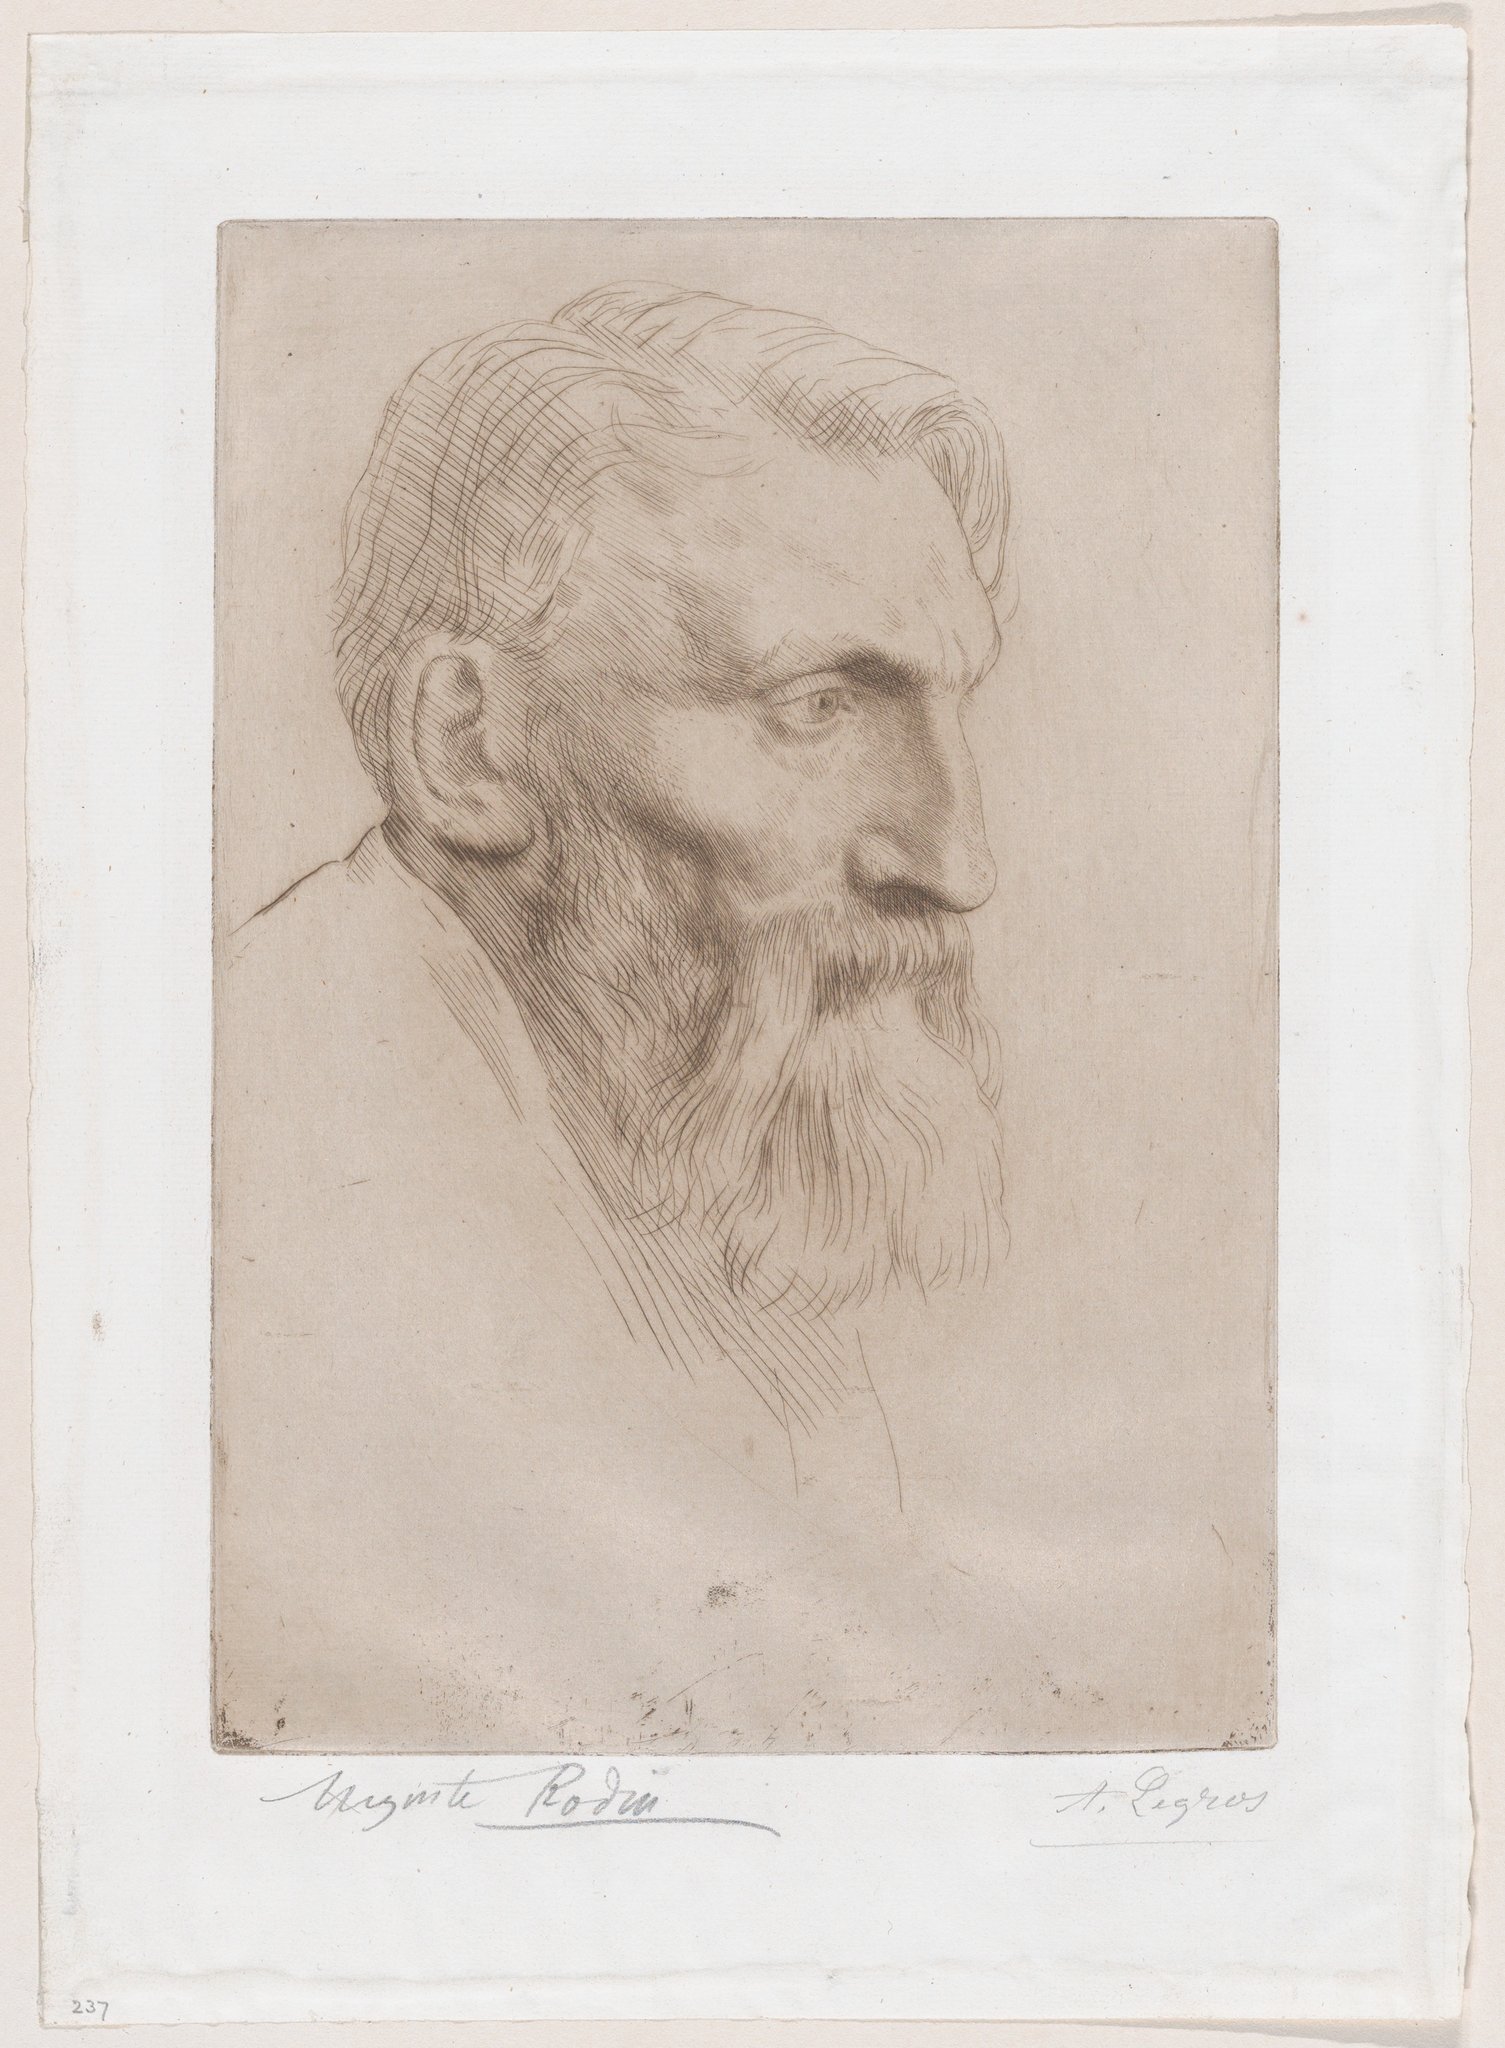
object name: print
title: Portrait of Auguste Rodin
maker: alphonse legros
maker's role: artist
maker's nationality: french and british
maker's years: 1837-1911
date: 1860-1910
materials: ink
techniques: etching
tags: men,portraits